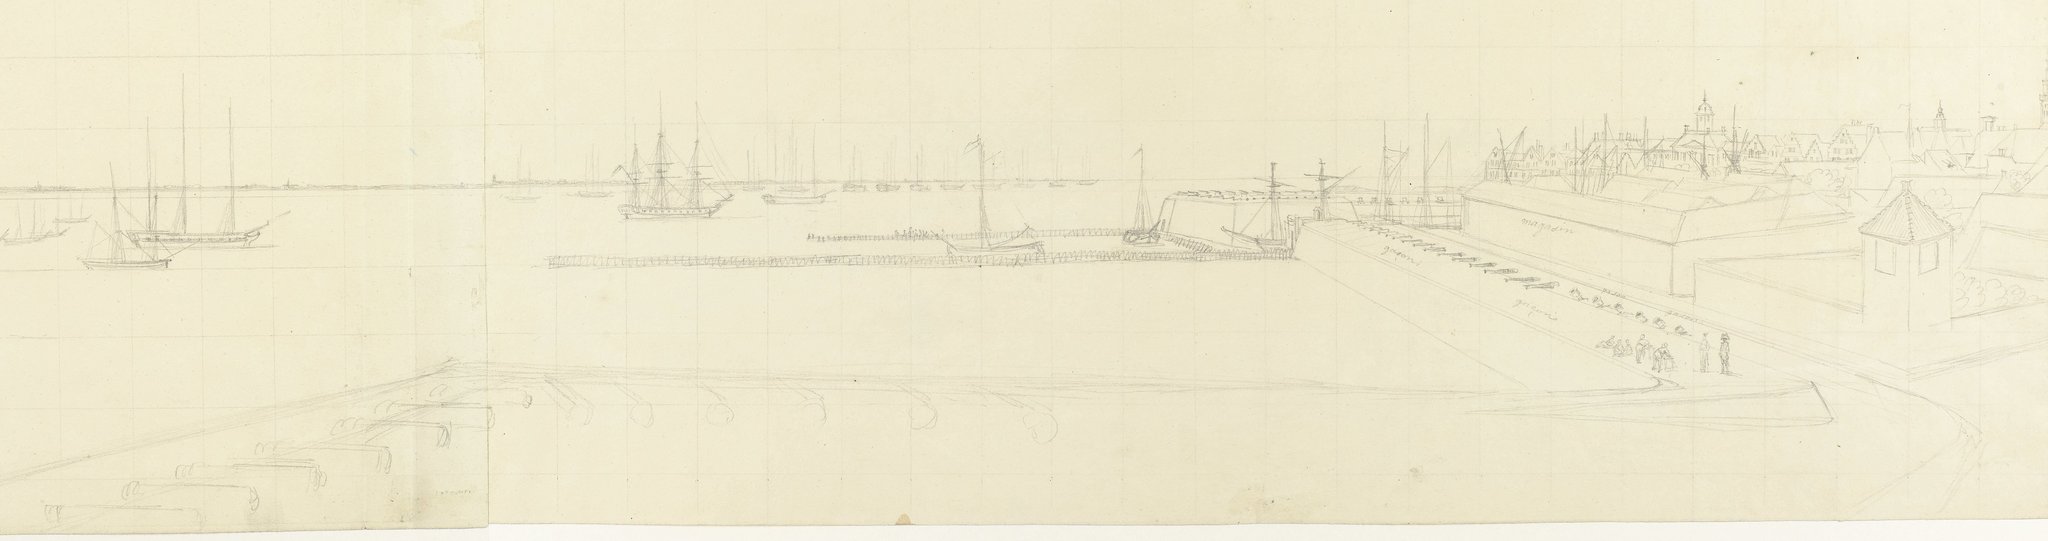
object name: topographical view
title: Gezicht op de rede van Vlissingen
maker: antoine ignace melling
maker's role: draughtsman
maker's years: 1763-1831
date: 1812-1814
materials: paper, pencil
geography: flushing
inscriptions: annotation: ‘Nº 5 / Flessingue avec la rade et l'embouchiere de l'Escau / Nº 5’